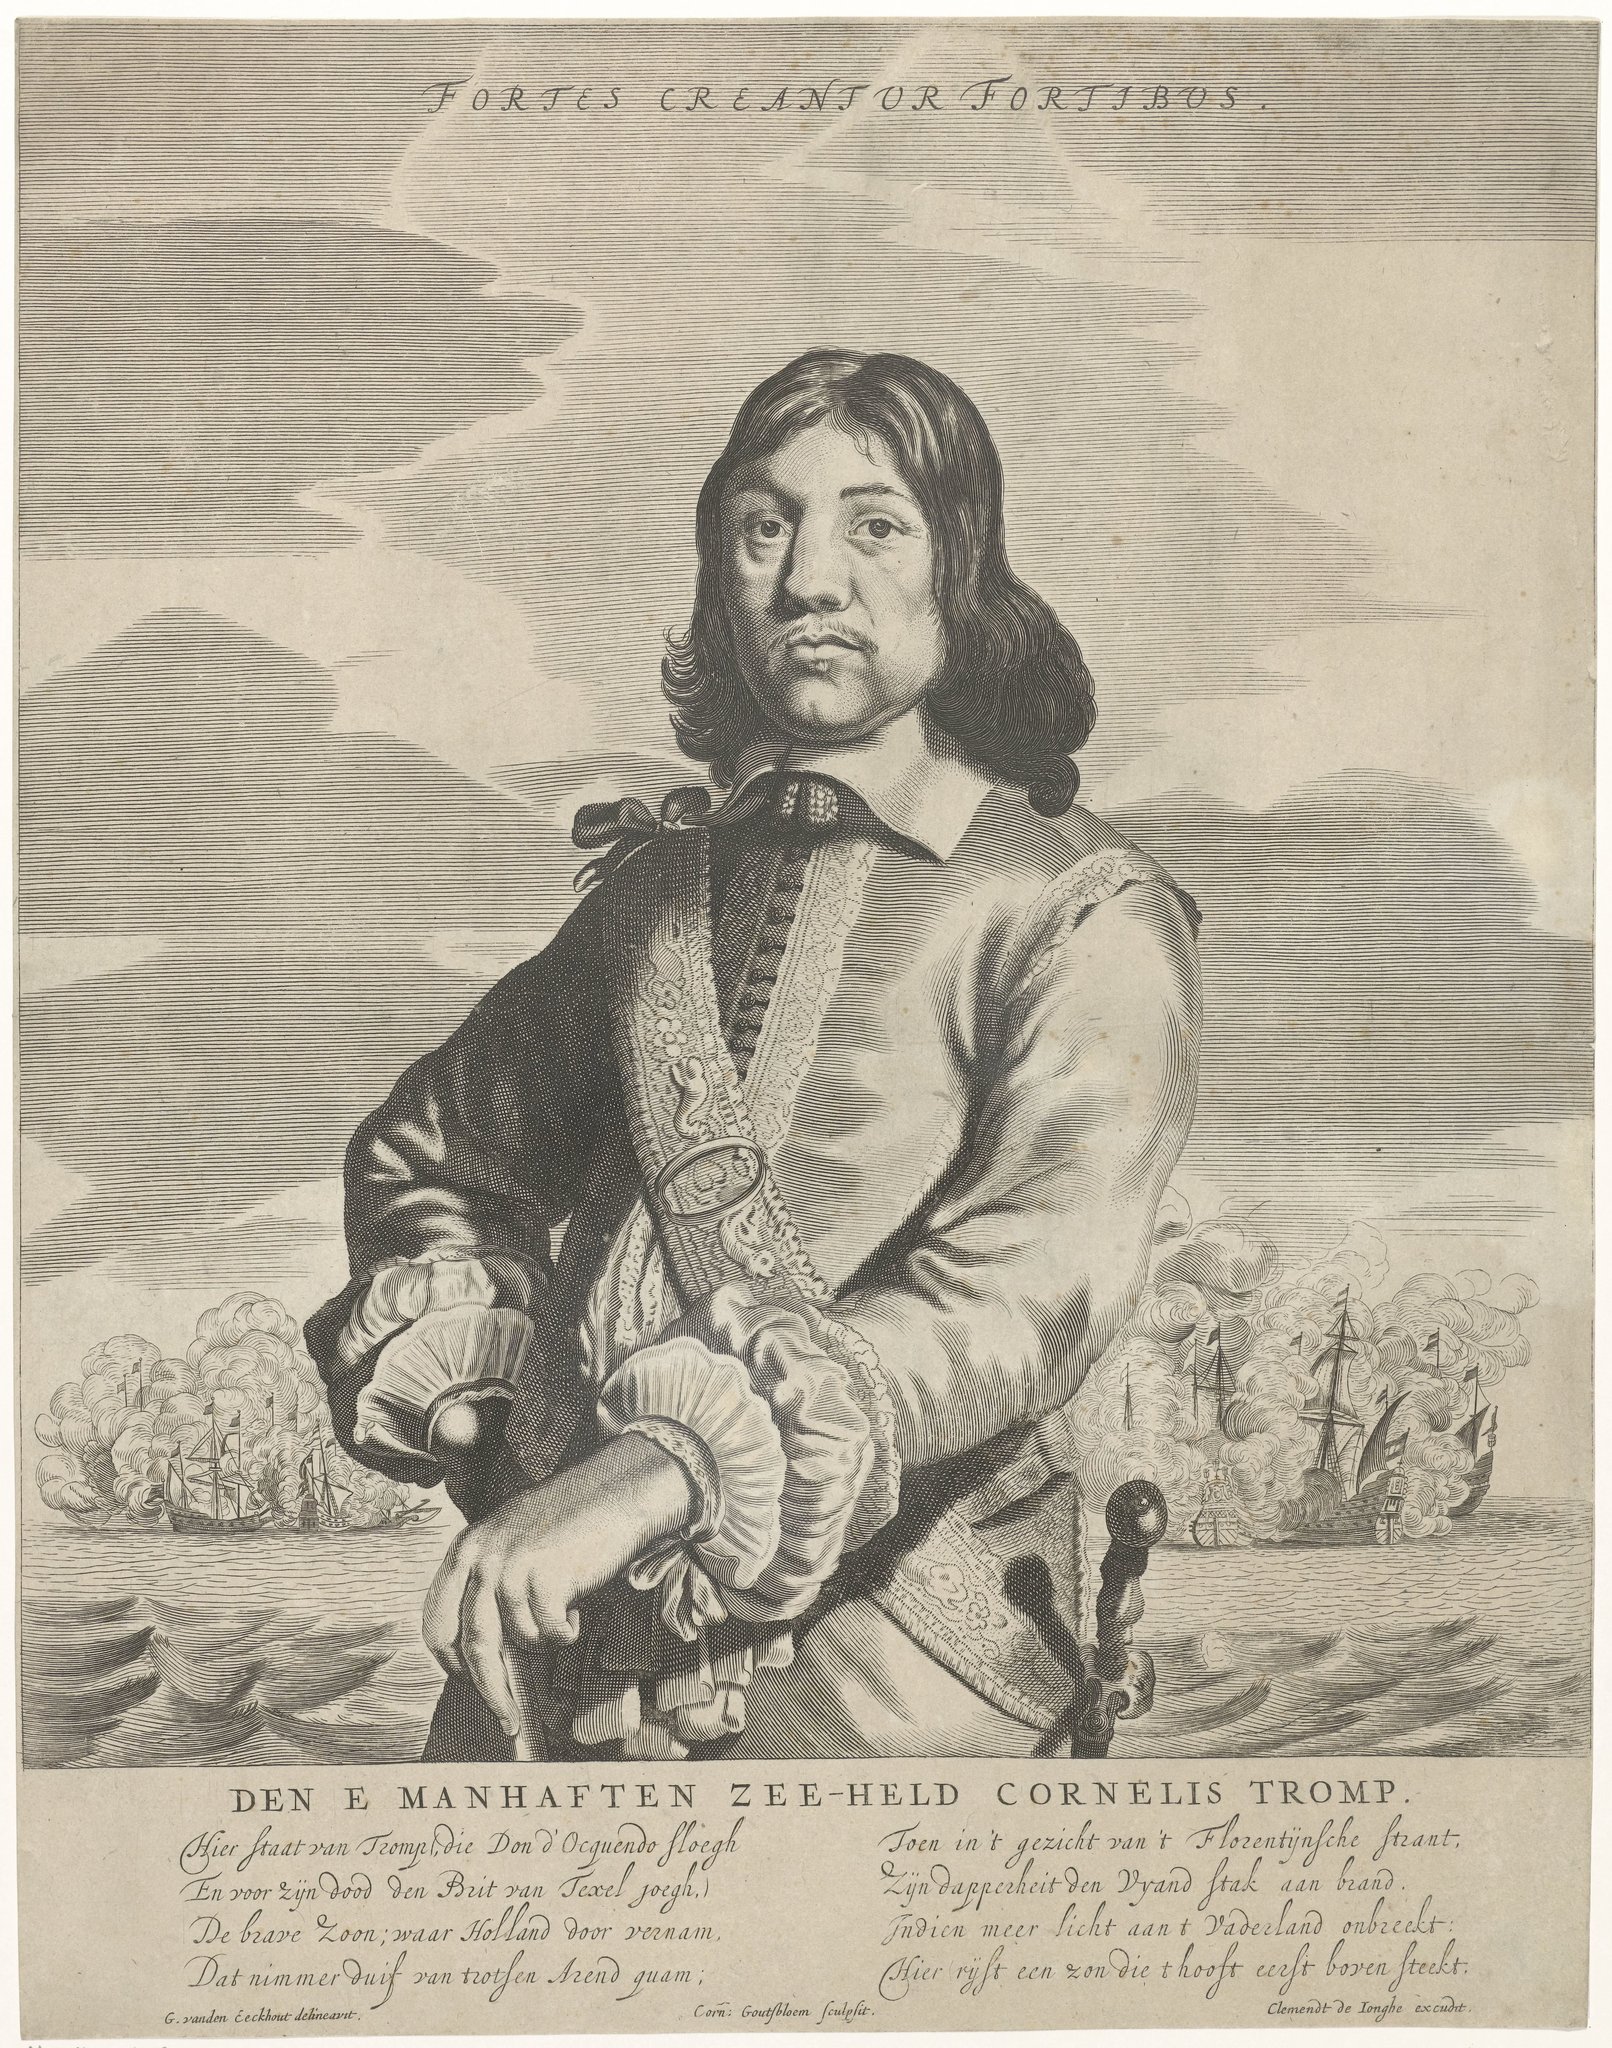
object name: print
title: Portret van admiraal Cornelis Tromp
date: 1653-1670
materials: paper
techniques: engraving, etching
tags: rotterdam, amsterdam, cornelis tromp, battle of leghorn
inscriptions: collector's mark: Lugt 2228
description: Portret van admiraal Cornelis Tromp, ten halven lijve naar links. Op de achtergrond een zeeslag, vermoedelijk de slag bij Livorno. De prent heeft een Nederlands gedicht als onderschrift